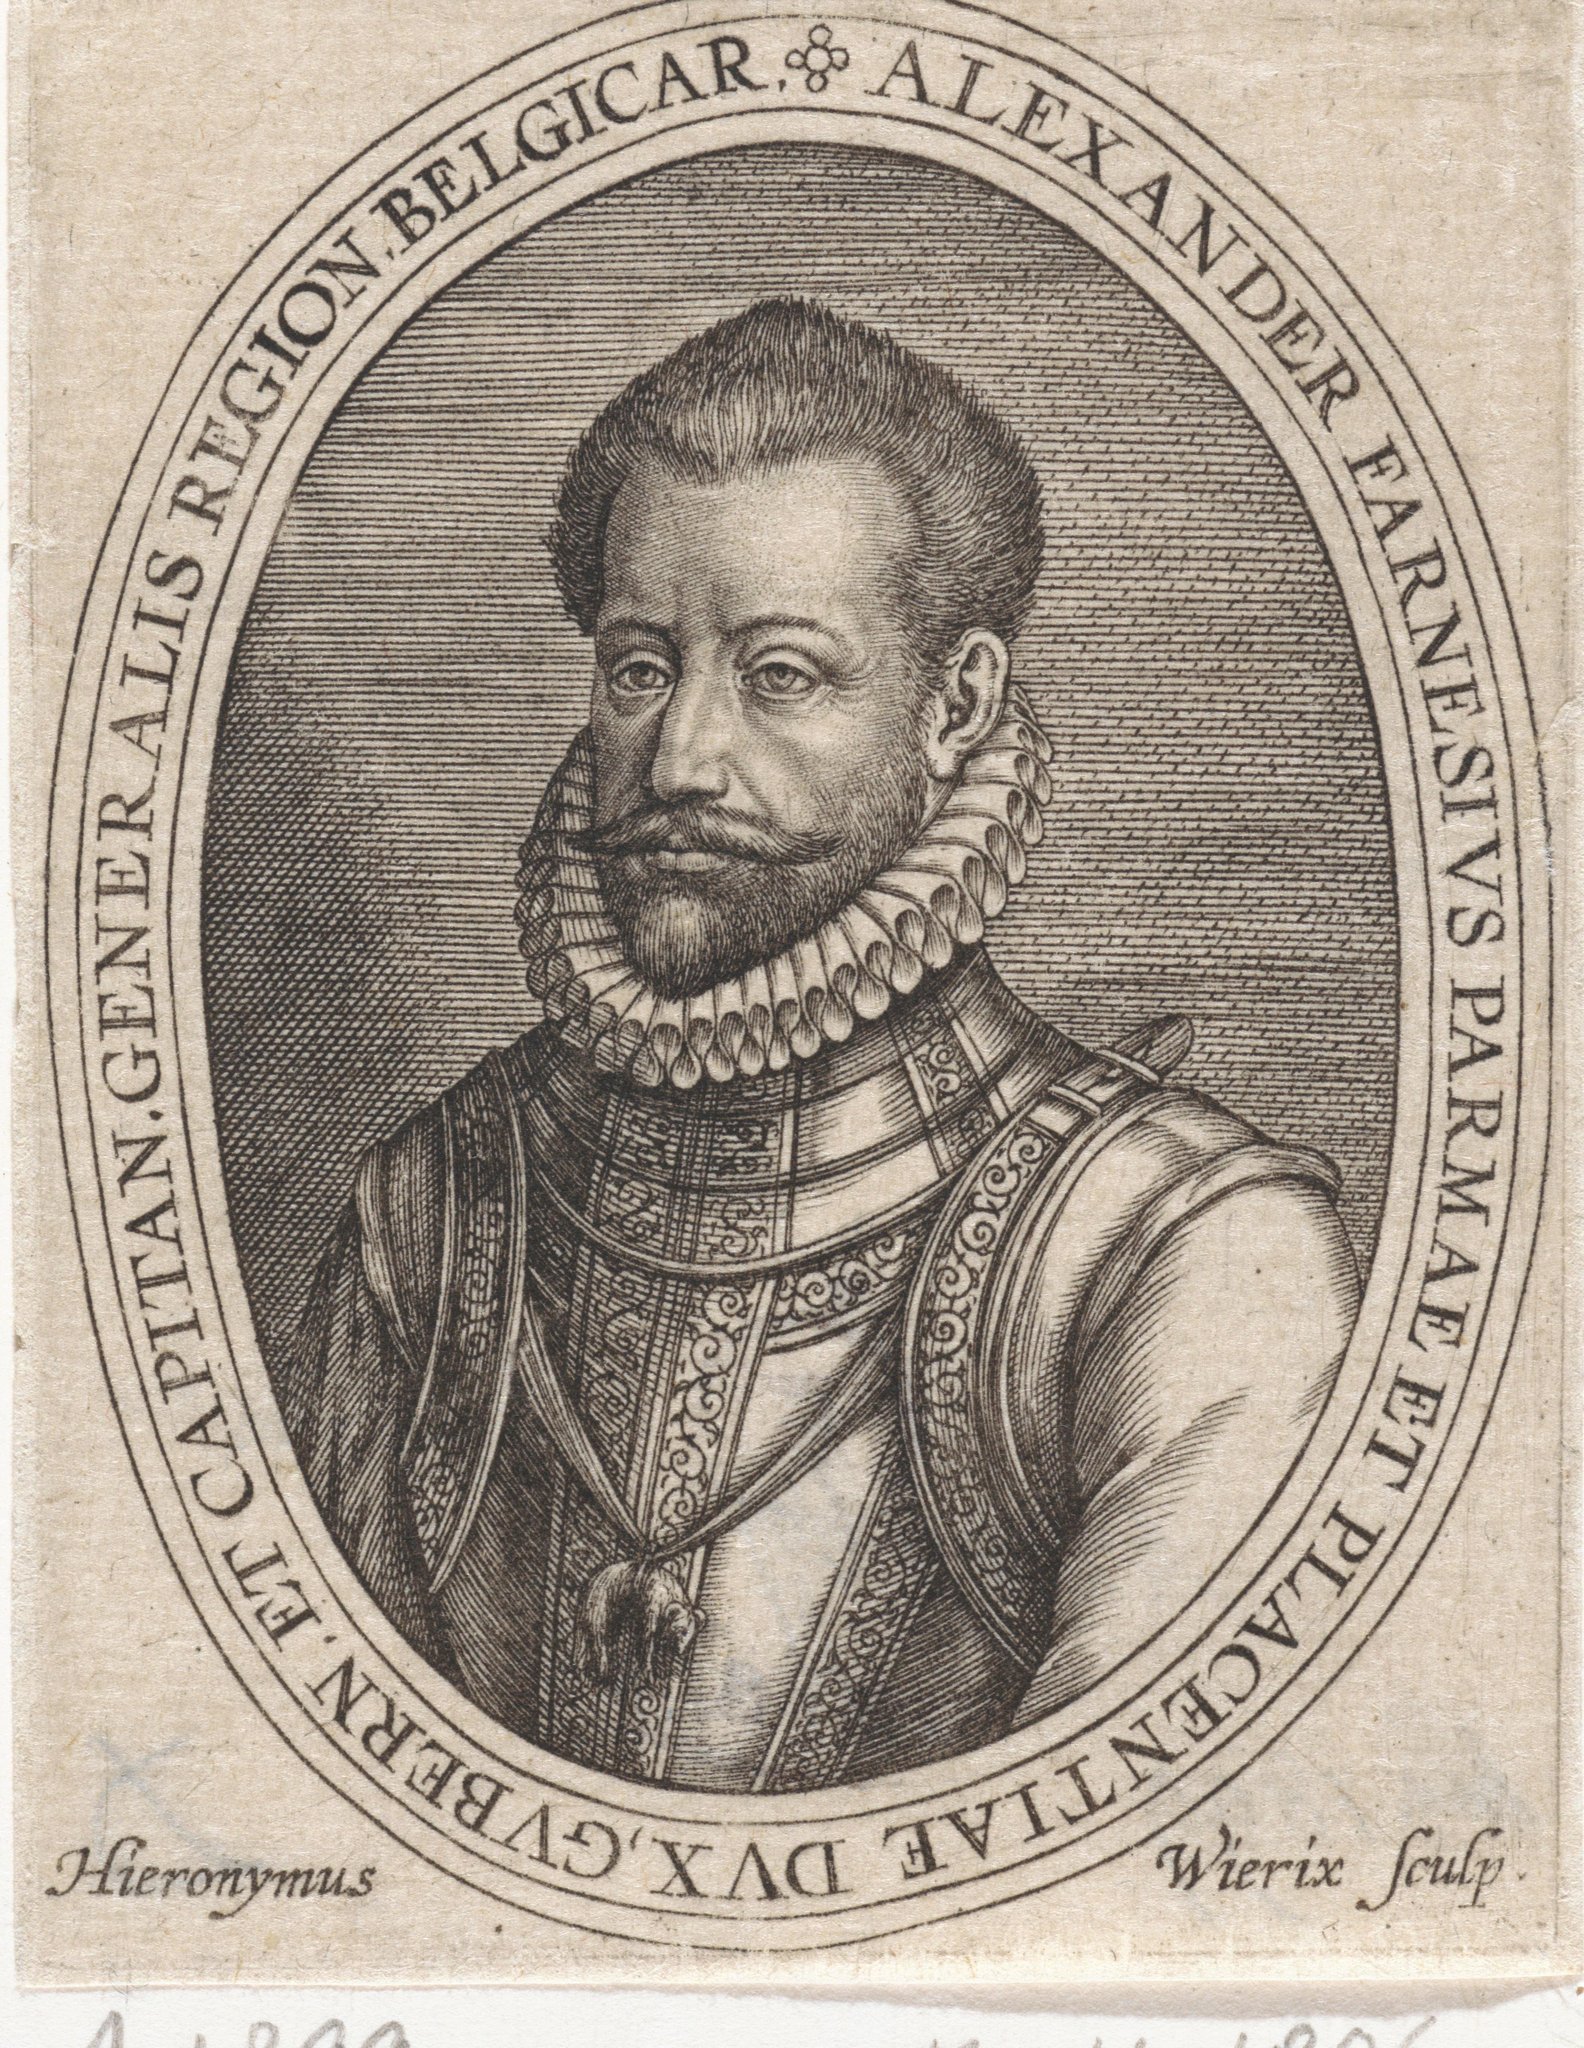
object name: print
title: Portret van Alessandro Farnese, hertog van Parma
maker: hieronymus wierix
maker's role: draughtsman, print maker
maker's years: 1553-1619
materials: paper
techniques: engraving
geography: antwerp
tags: rome, alessandro farnese (landvoogd van de nederlanden en hertog van parma en piacenza), armour, knighthood order of the golden fleece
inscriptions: collector's mark: Lugt 964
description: Hij draagt een harnas en een lint met de Orde van het Gulden Vlies. Zijn portret is gevat in een ovale omlijsting met een randschrift in het Latijn.